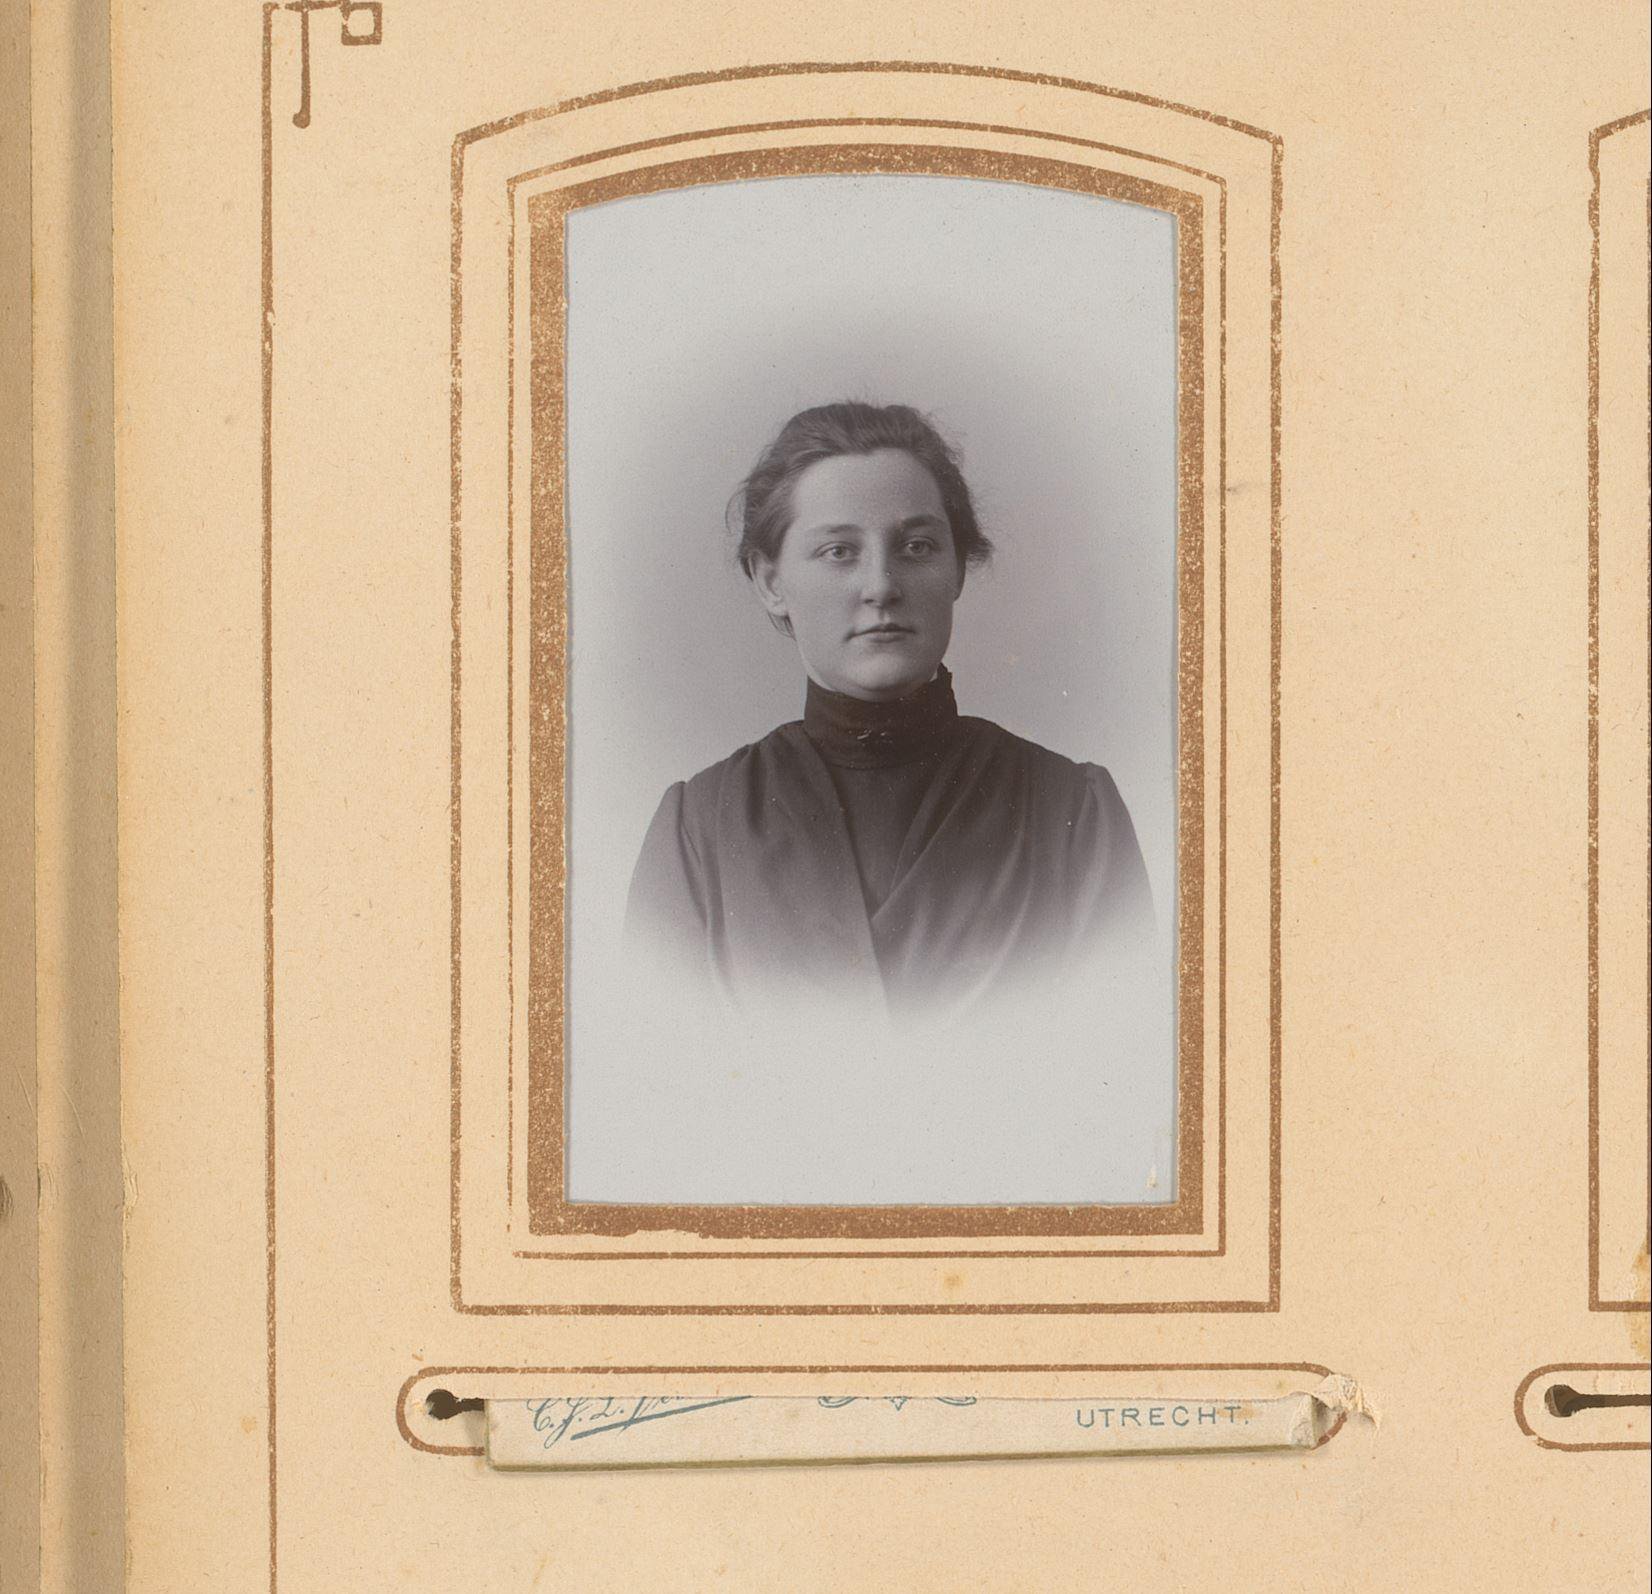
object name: album leaf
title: Portret van een jonge vrouw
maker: cornelis johannes lodewicus vermeulen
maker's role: fotograaf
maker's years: 1861-1936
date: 1880-1900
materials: cardboard, photographic support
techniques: collodion silver print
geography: amsterdam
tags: adolescent, young woman, maiden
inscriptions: inscription: ‘C.J.L. Vermeulen/ Den Haag/ Amsterdam/ Utrecht’